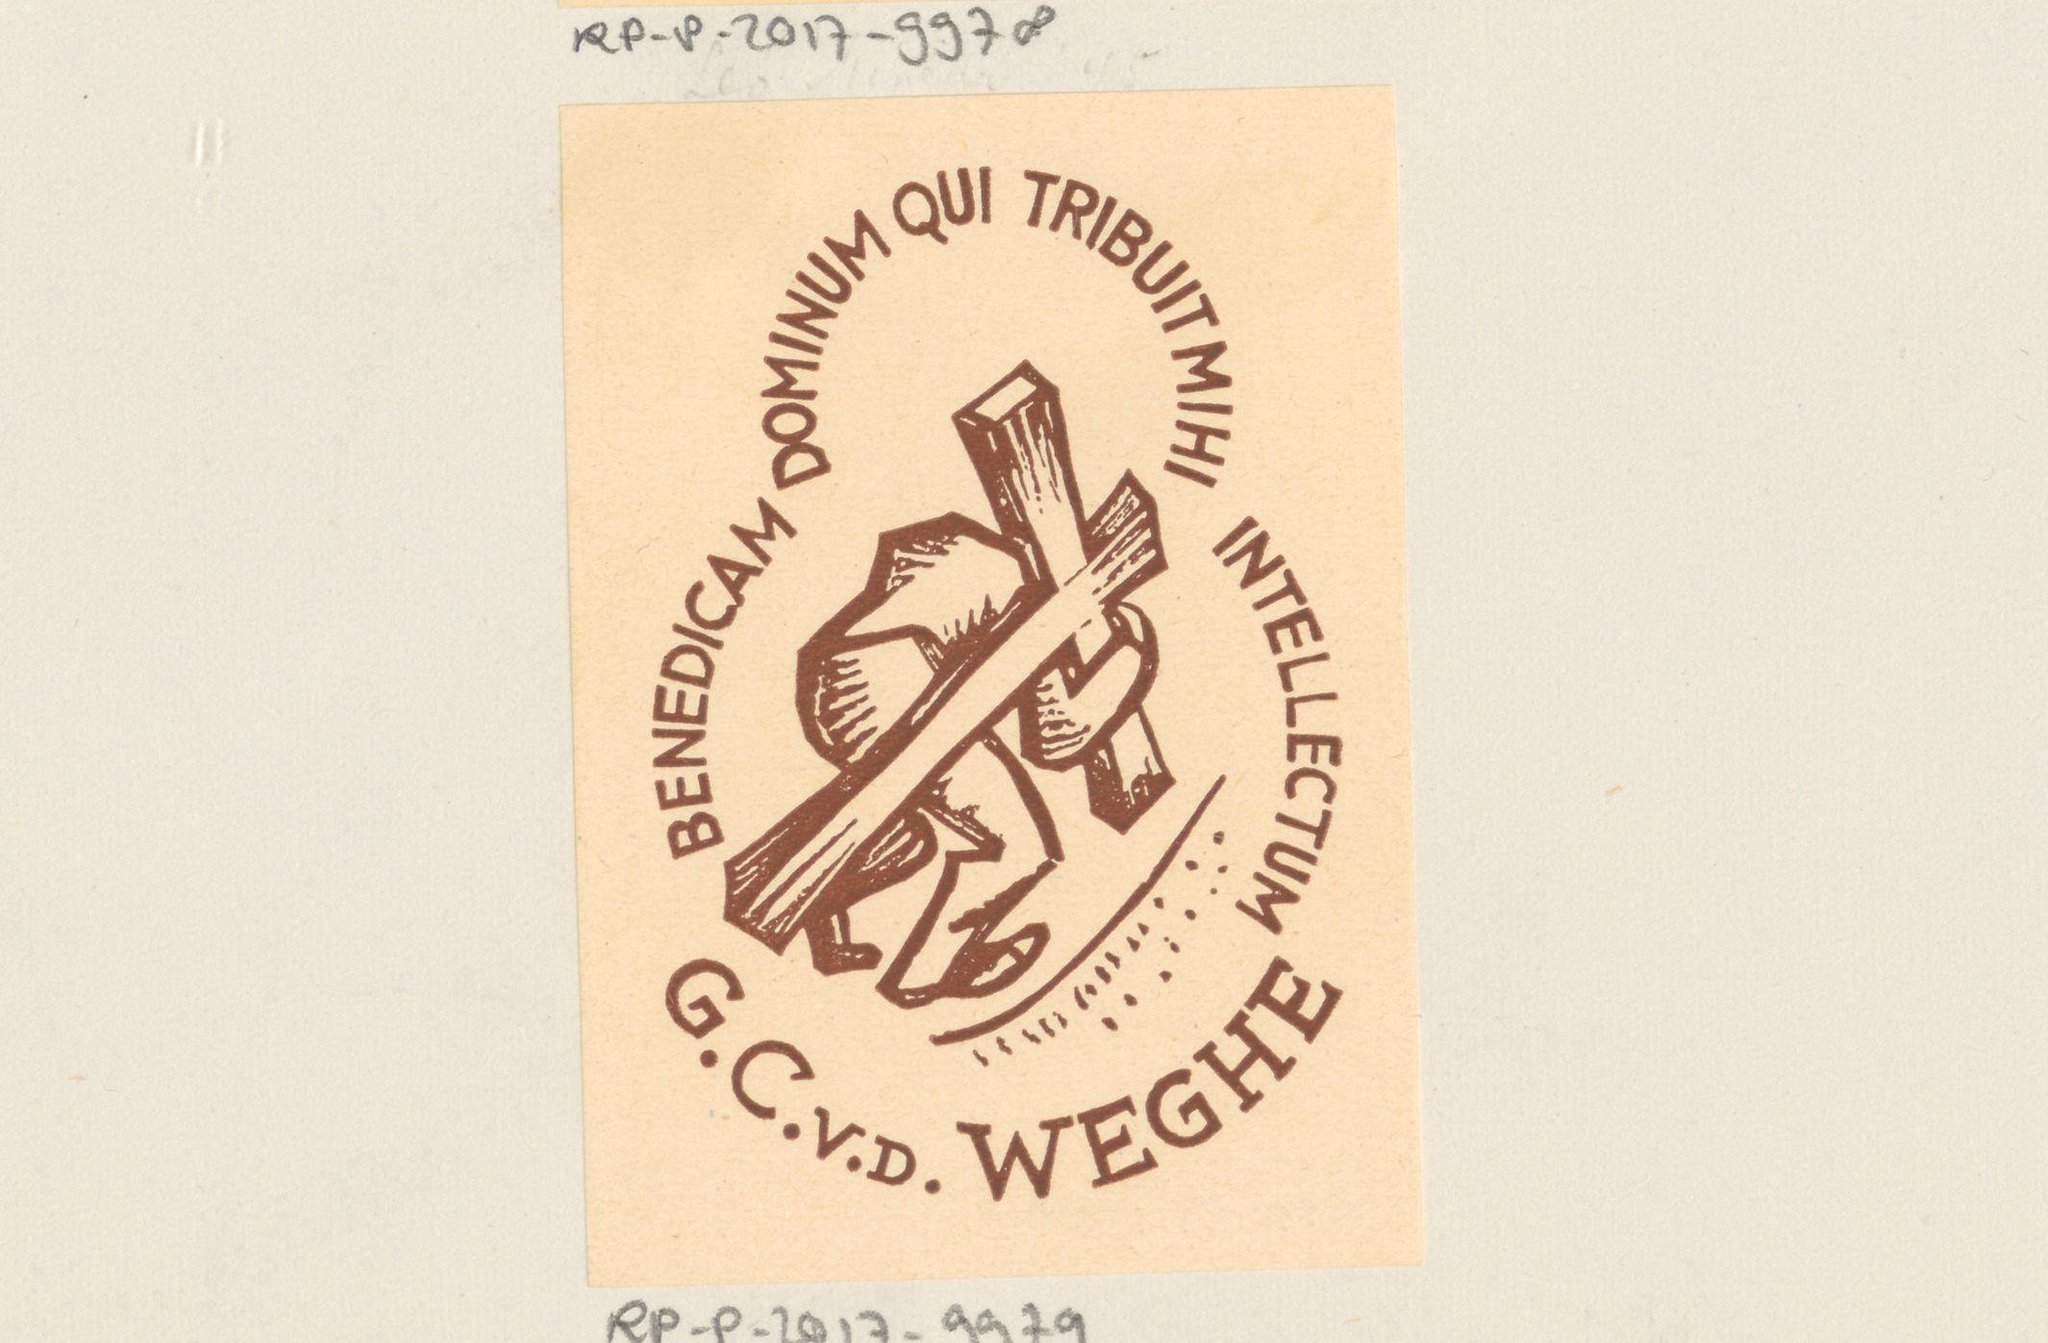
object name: bookplate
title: Ex libris van G.C. v.d. Weghe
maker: Anonymous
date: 1945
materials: paper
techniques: printing block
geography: netherlands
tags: carrying something, the cross ~ symbols of christ